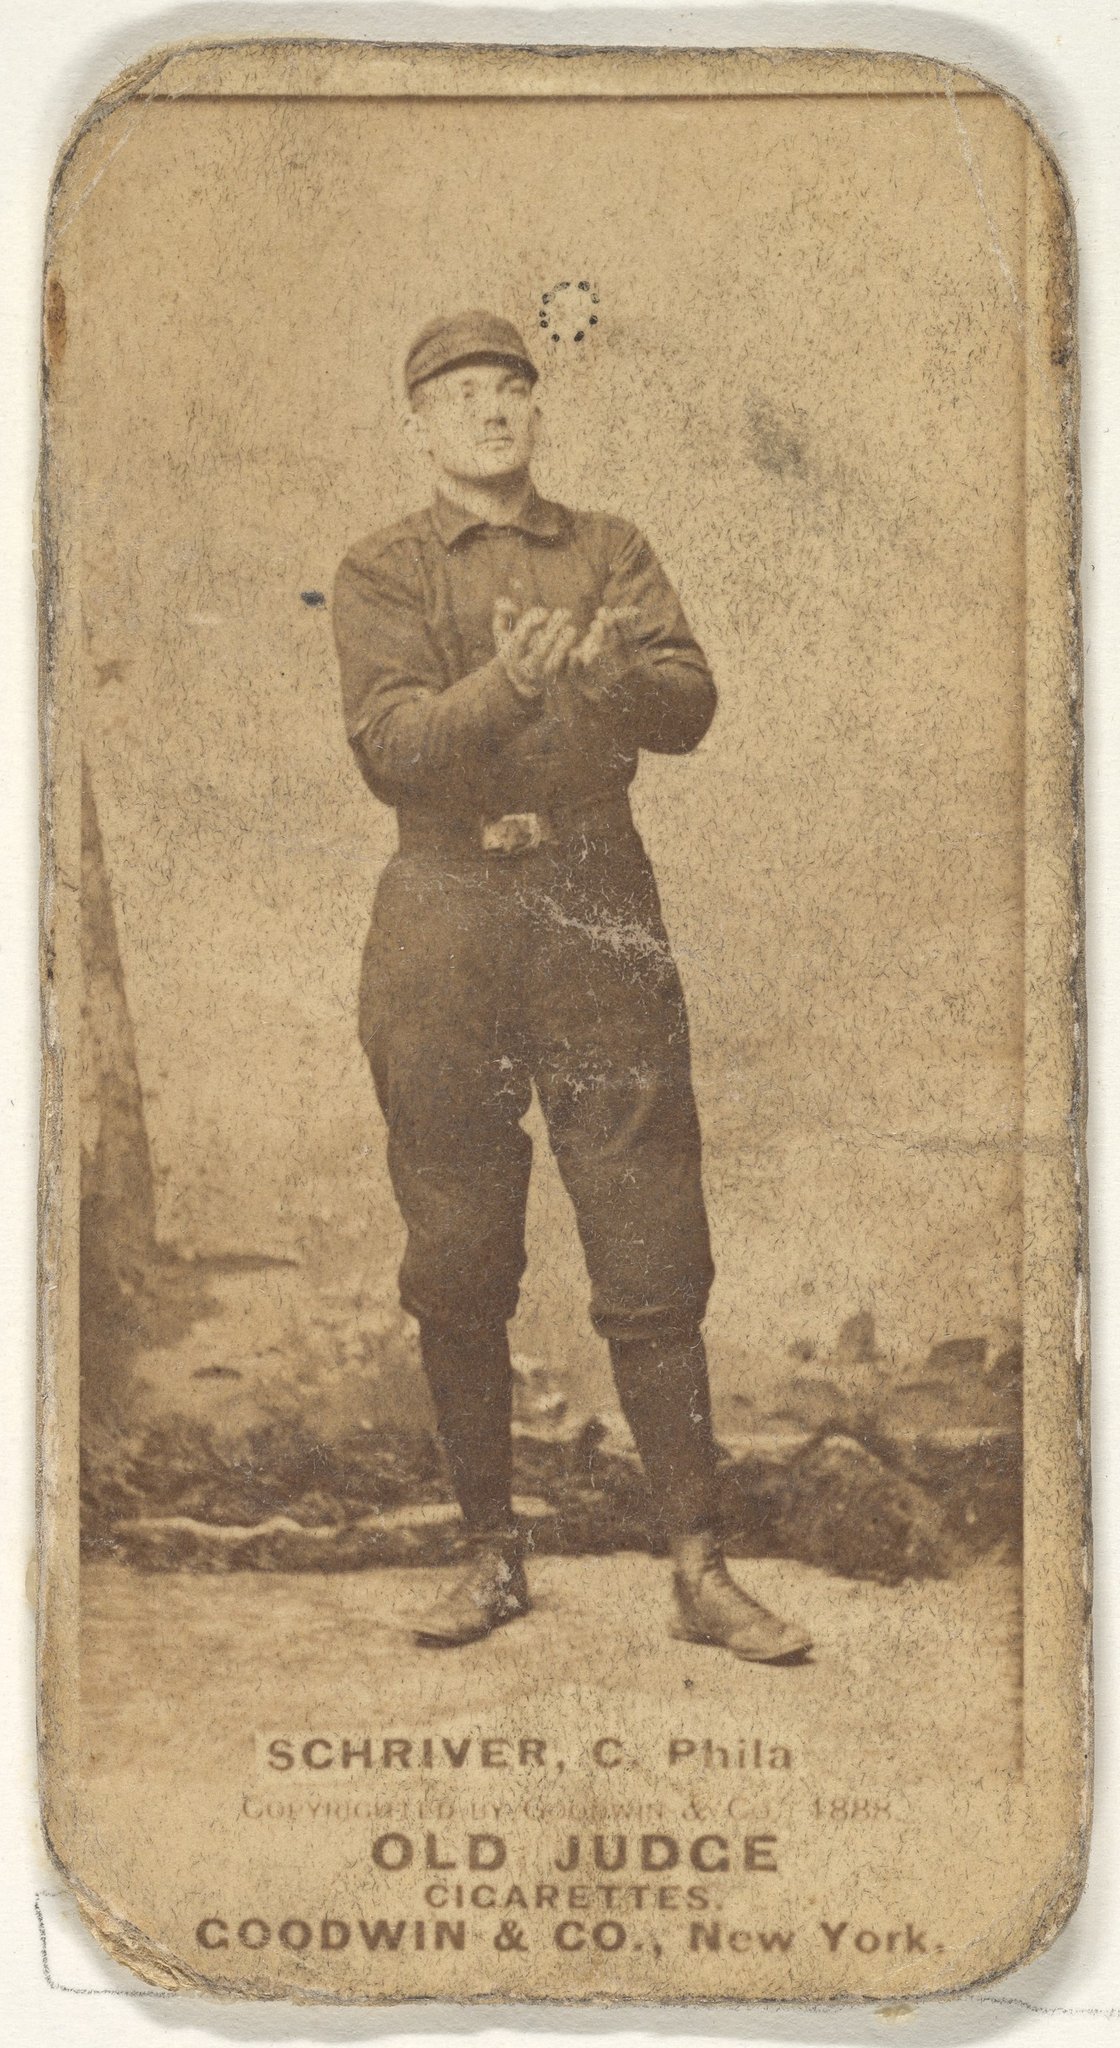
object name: baseball card, photograph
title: William Frederick "Pop" Schriver, Catcher, Philadelphia, from the Old Judge series (N172) for Old Judge Cigarettes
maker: goodwin & company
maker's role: publisher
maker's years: 1850-1950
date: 1888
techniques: albumen silver print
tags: men,portraits,baseball,athletes